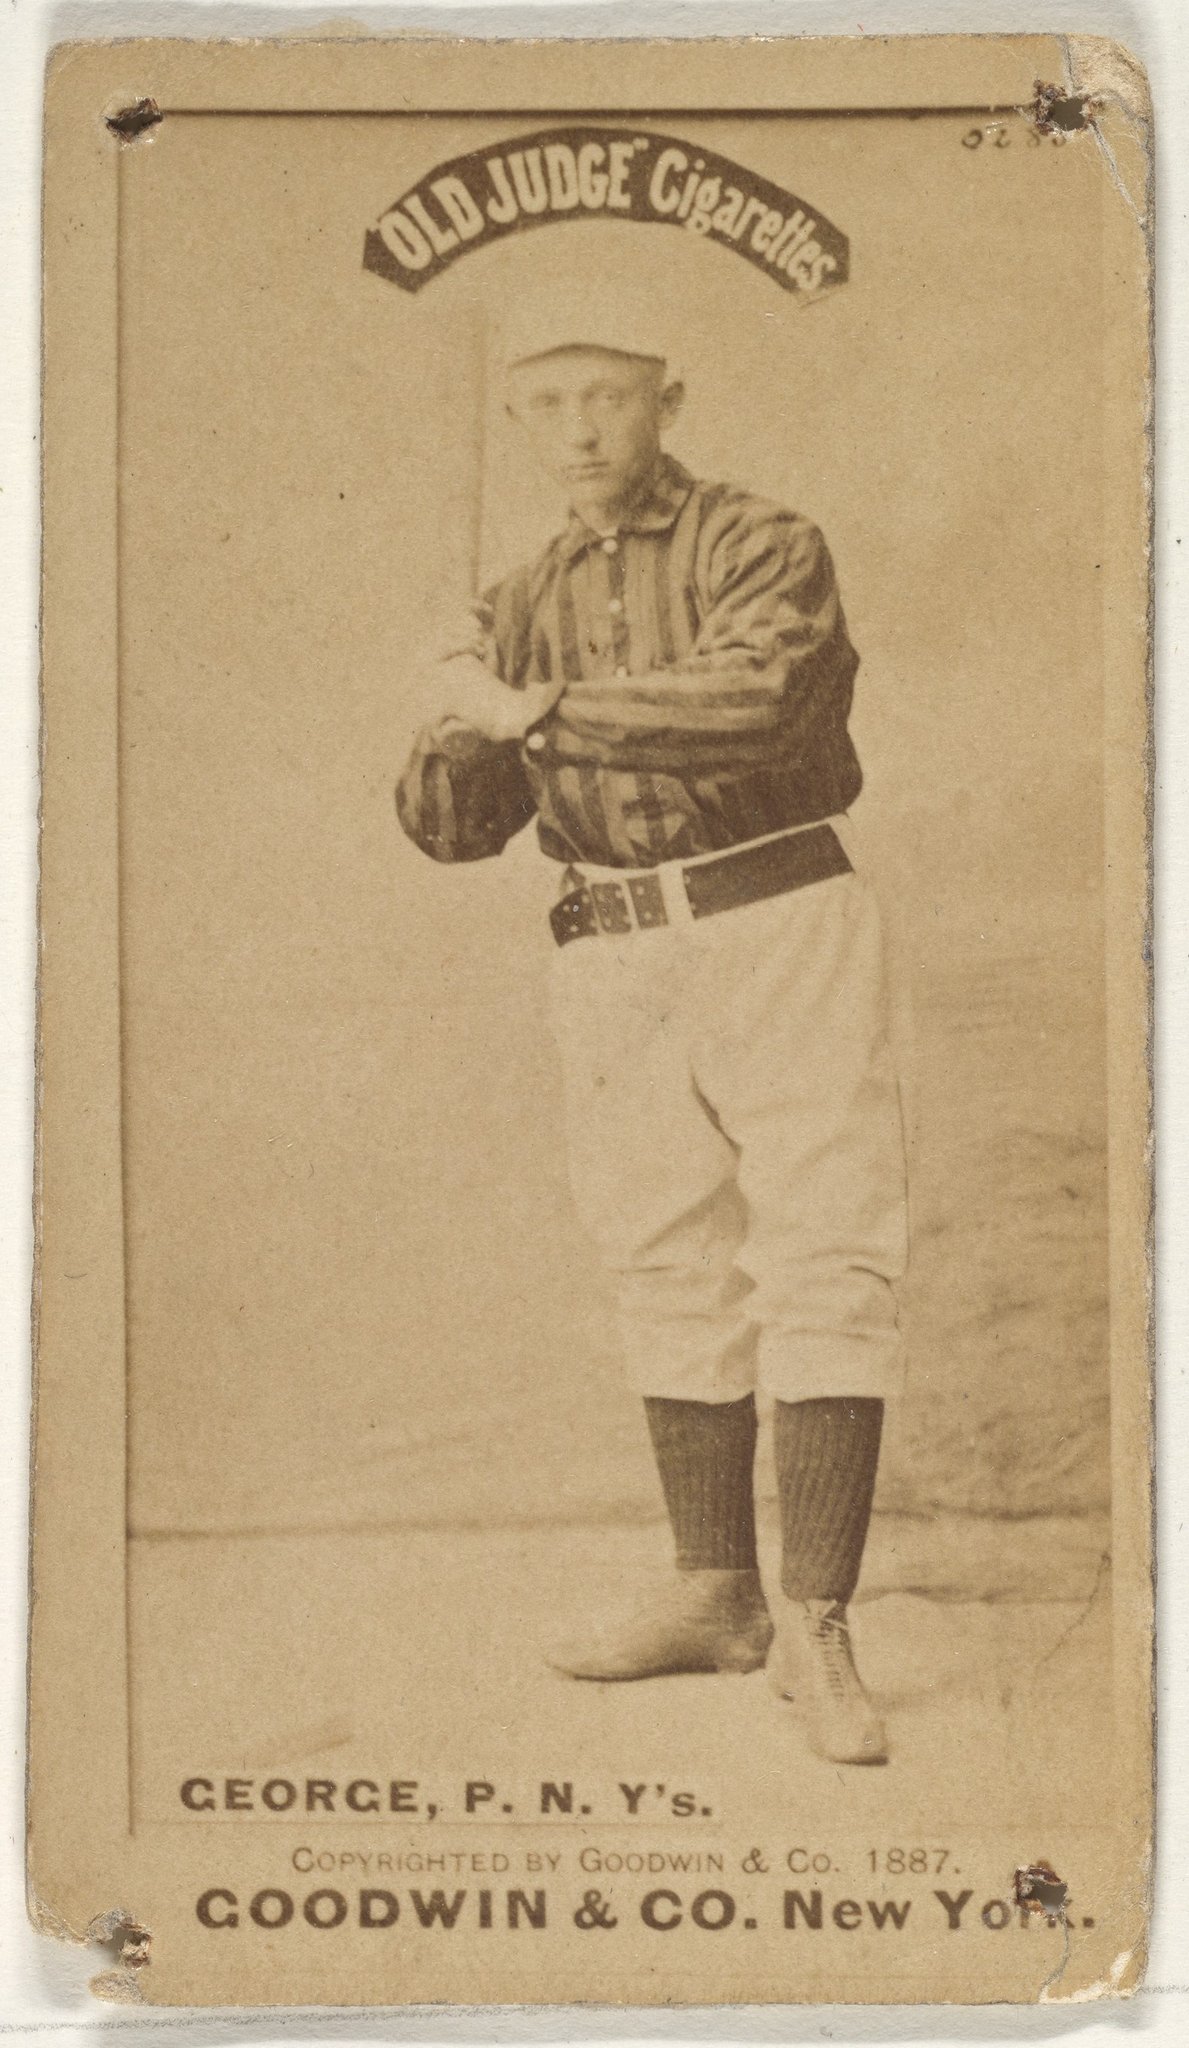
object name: baseball card, photograph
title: Bill George, Pitcher, New York, from the Old Judge series (N172) for Old Judge Cigarettes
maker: goodwin & company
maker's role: publisher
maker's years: 1850-1950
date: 1887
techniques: albumen silver print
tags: men,portraits,baseball,athletes